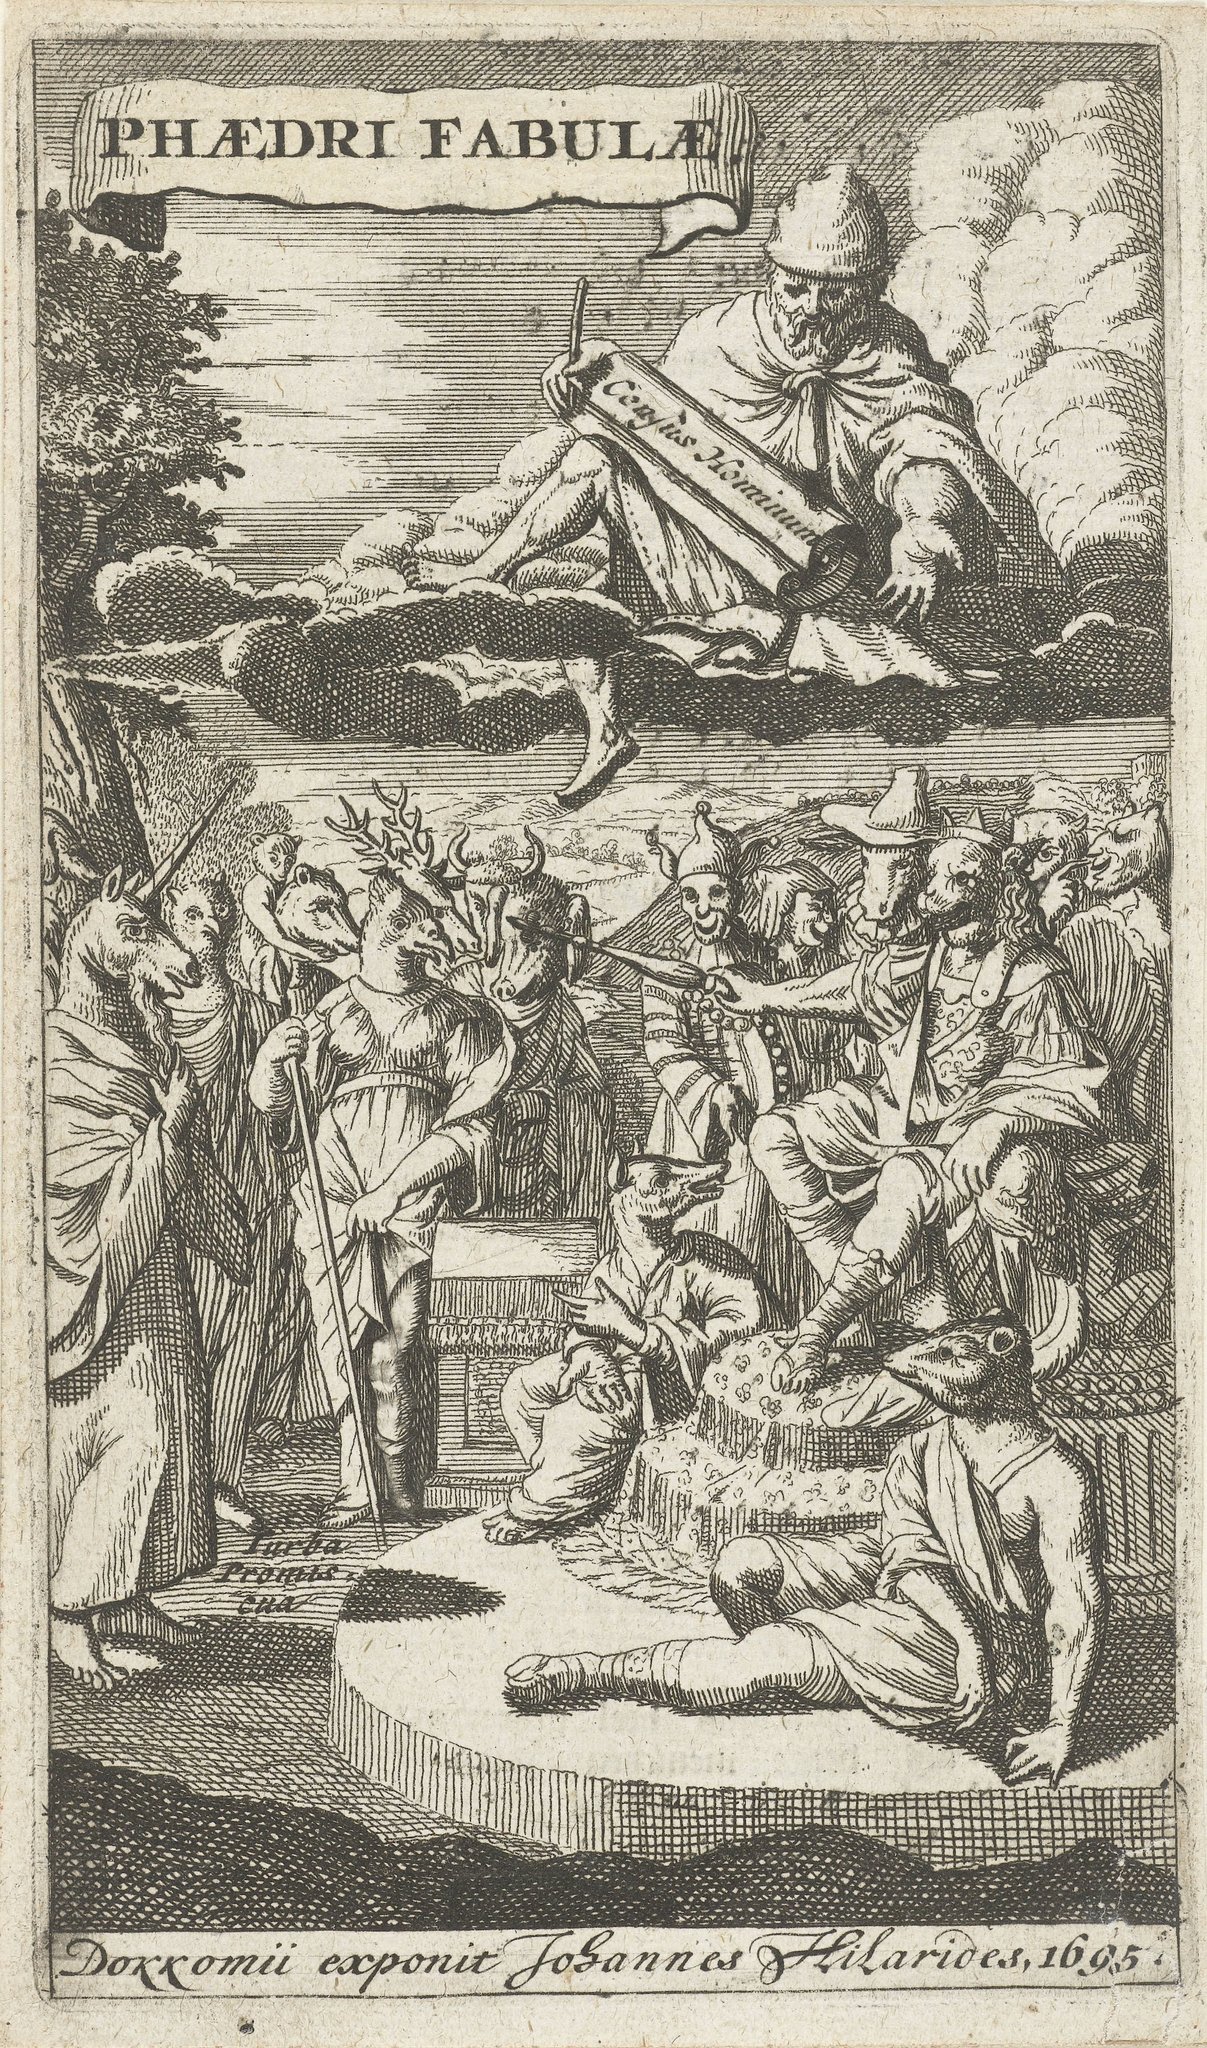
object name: titelblad, titelpagina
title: Phaedri Fabulae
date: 1695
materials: paper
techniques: engraving, etching, letterpress printing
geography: dokkum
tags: other fables : use 85(...)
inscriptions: collector's mark: Lugt 2228, collector's mark: Lugt 2760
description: Groep van verscheidene figuren, half mens en half dier, gegroepeerd rond een troon. Daarboven een figuur op een wolk met een rol papier in zijn handen, naar beneden kijkend. Afbeelding uit Fabulae Æsopiæ, daarachter drie pagina's met tekst in het Nederlands, in boekdruk.